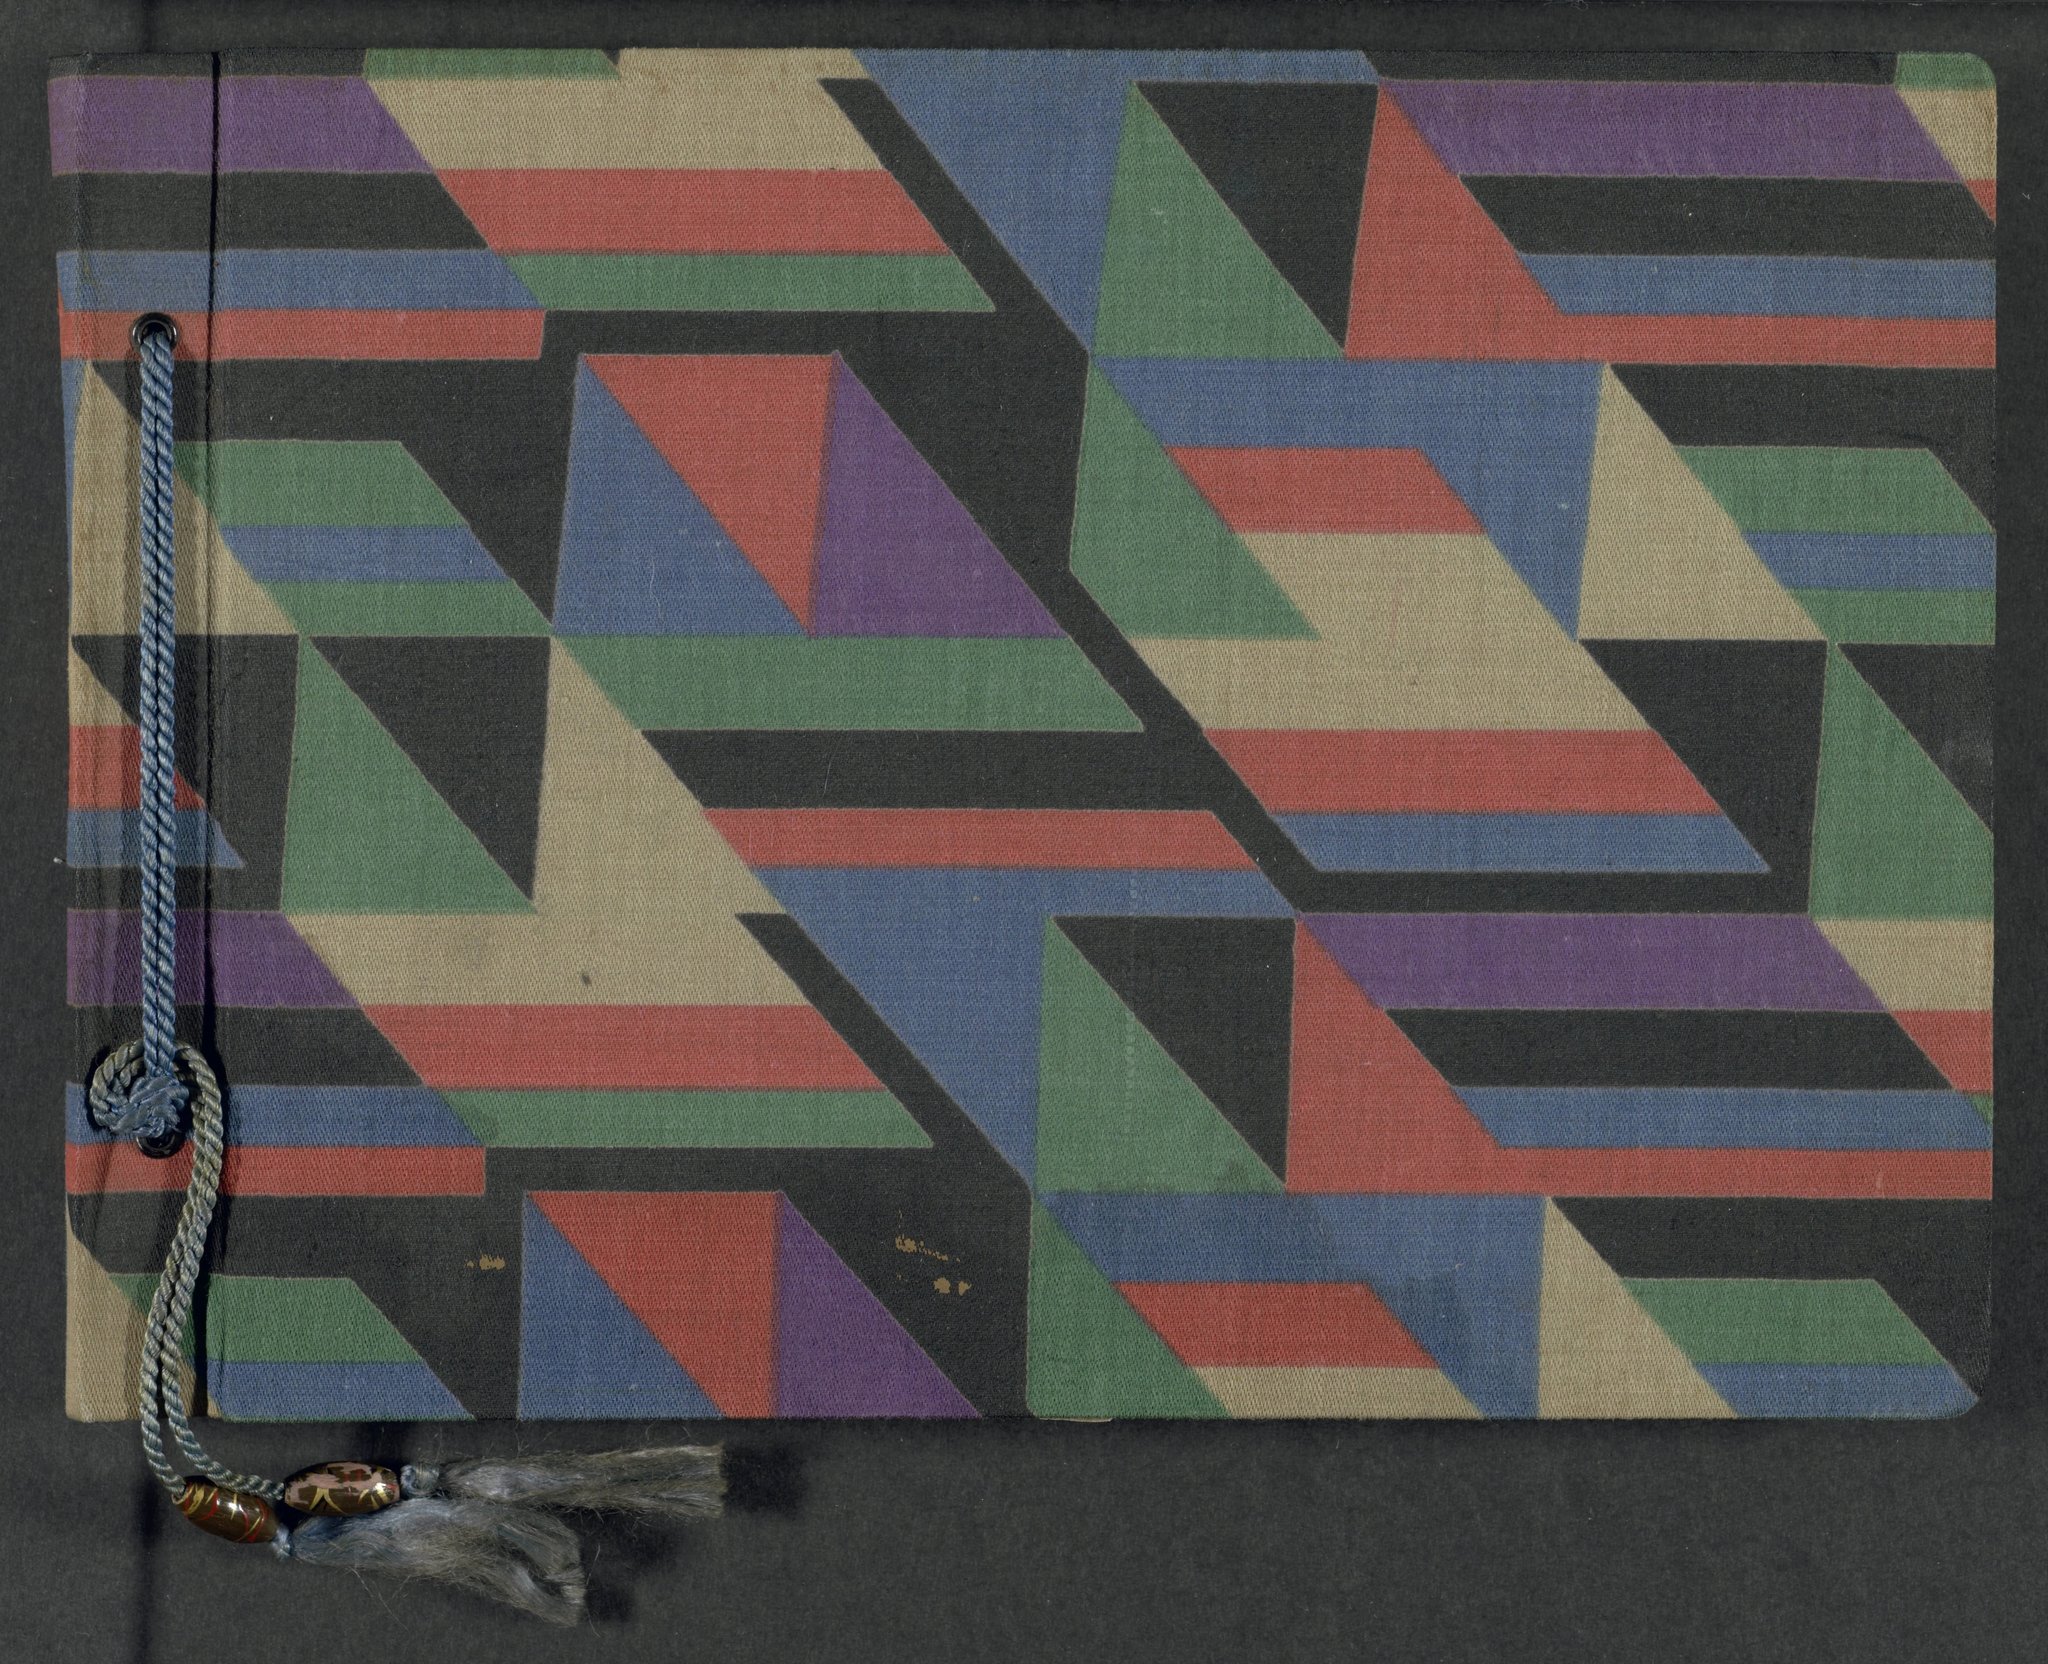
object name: photograph album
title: Familiealbum Nederlands-Indië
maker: Anonymous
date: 1920-1930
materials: cardboard, paper, linen, photographic support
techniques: gelatin silver print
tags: netherlands, dutch east indies, the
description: Fotoalbum met opnames van een familie in Nederlands-Indië en de reis per schip daar naartoe via het Suezkanaal. Het album bevat 50 bladen die aan weerszijden met 145 foto's beplakt zijn. Tussen de bladen pergamijn. Foto's van onder andere het vertrek, het leven aan boord en tussenstops in Genua en Colombo. Van Nederlands-Indië opnames van olieboortorens, olieopslagplaatsen, havens, reizen naar het binnenland, huiselijke taferelen en een optocht. De omslag van het album is van linnen met geometrische patronen in art-decostijl. Het wordt bij elkaar gehouden door een koord met twee beschilderde kralen en kwastjes.